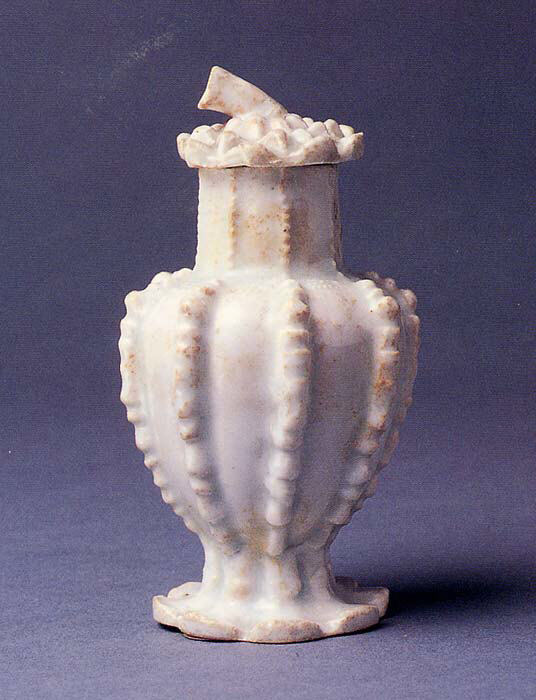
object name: jar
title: Covered Jar in the Shape of a Star Fruit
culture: chinese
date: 1301-1400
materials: glaze, porcelain